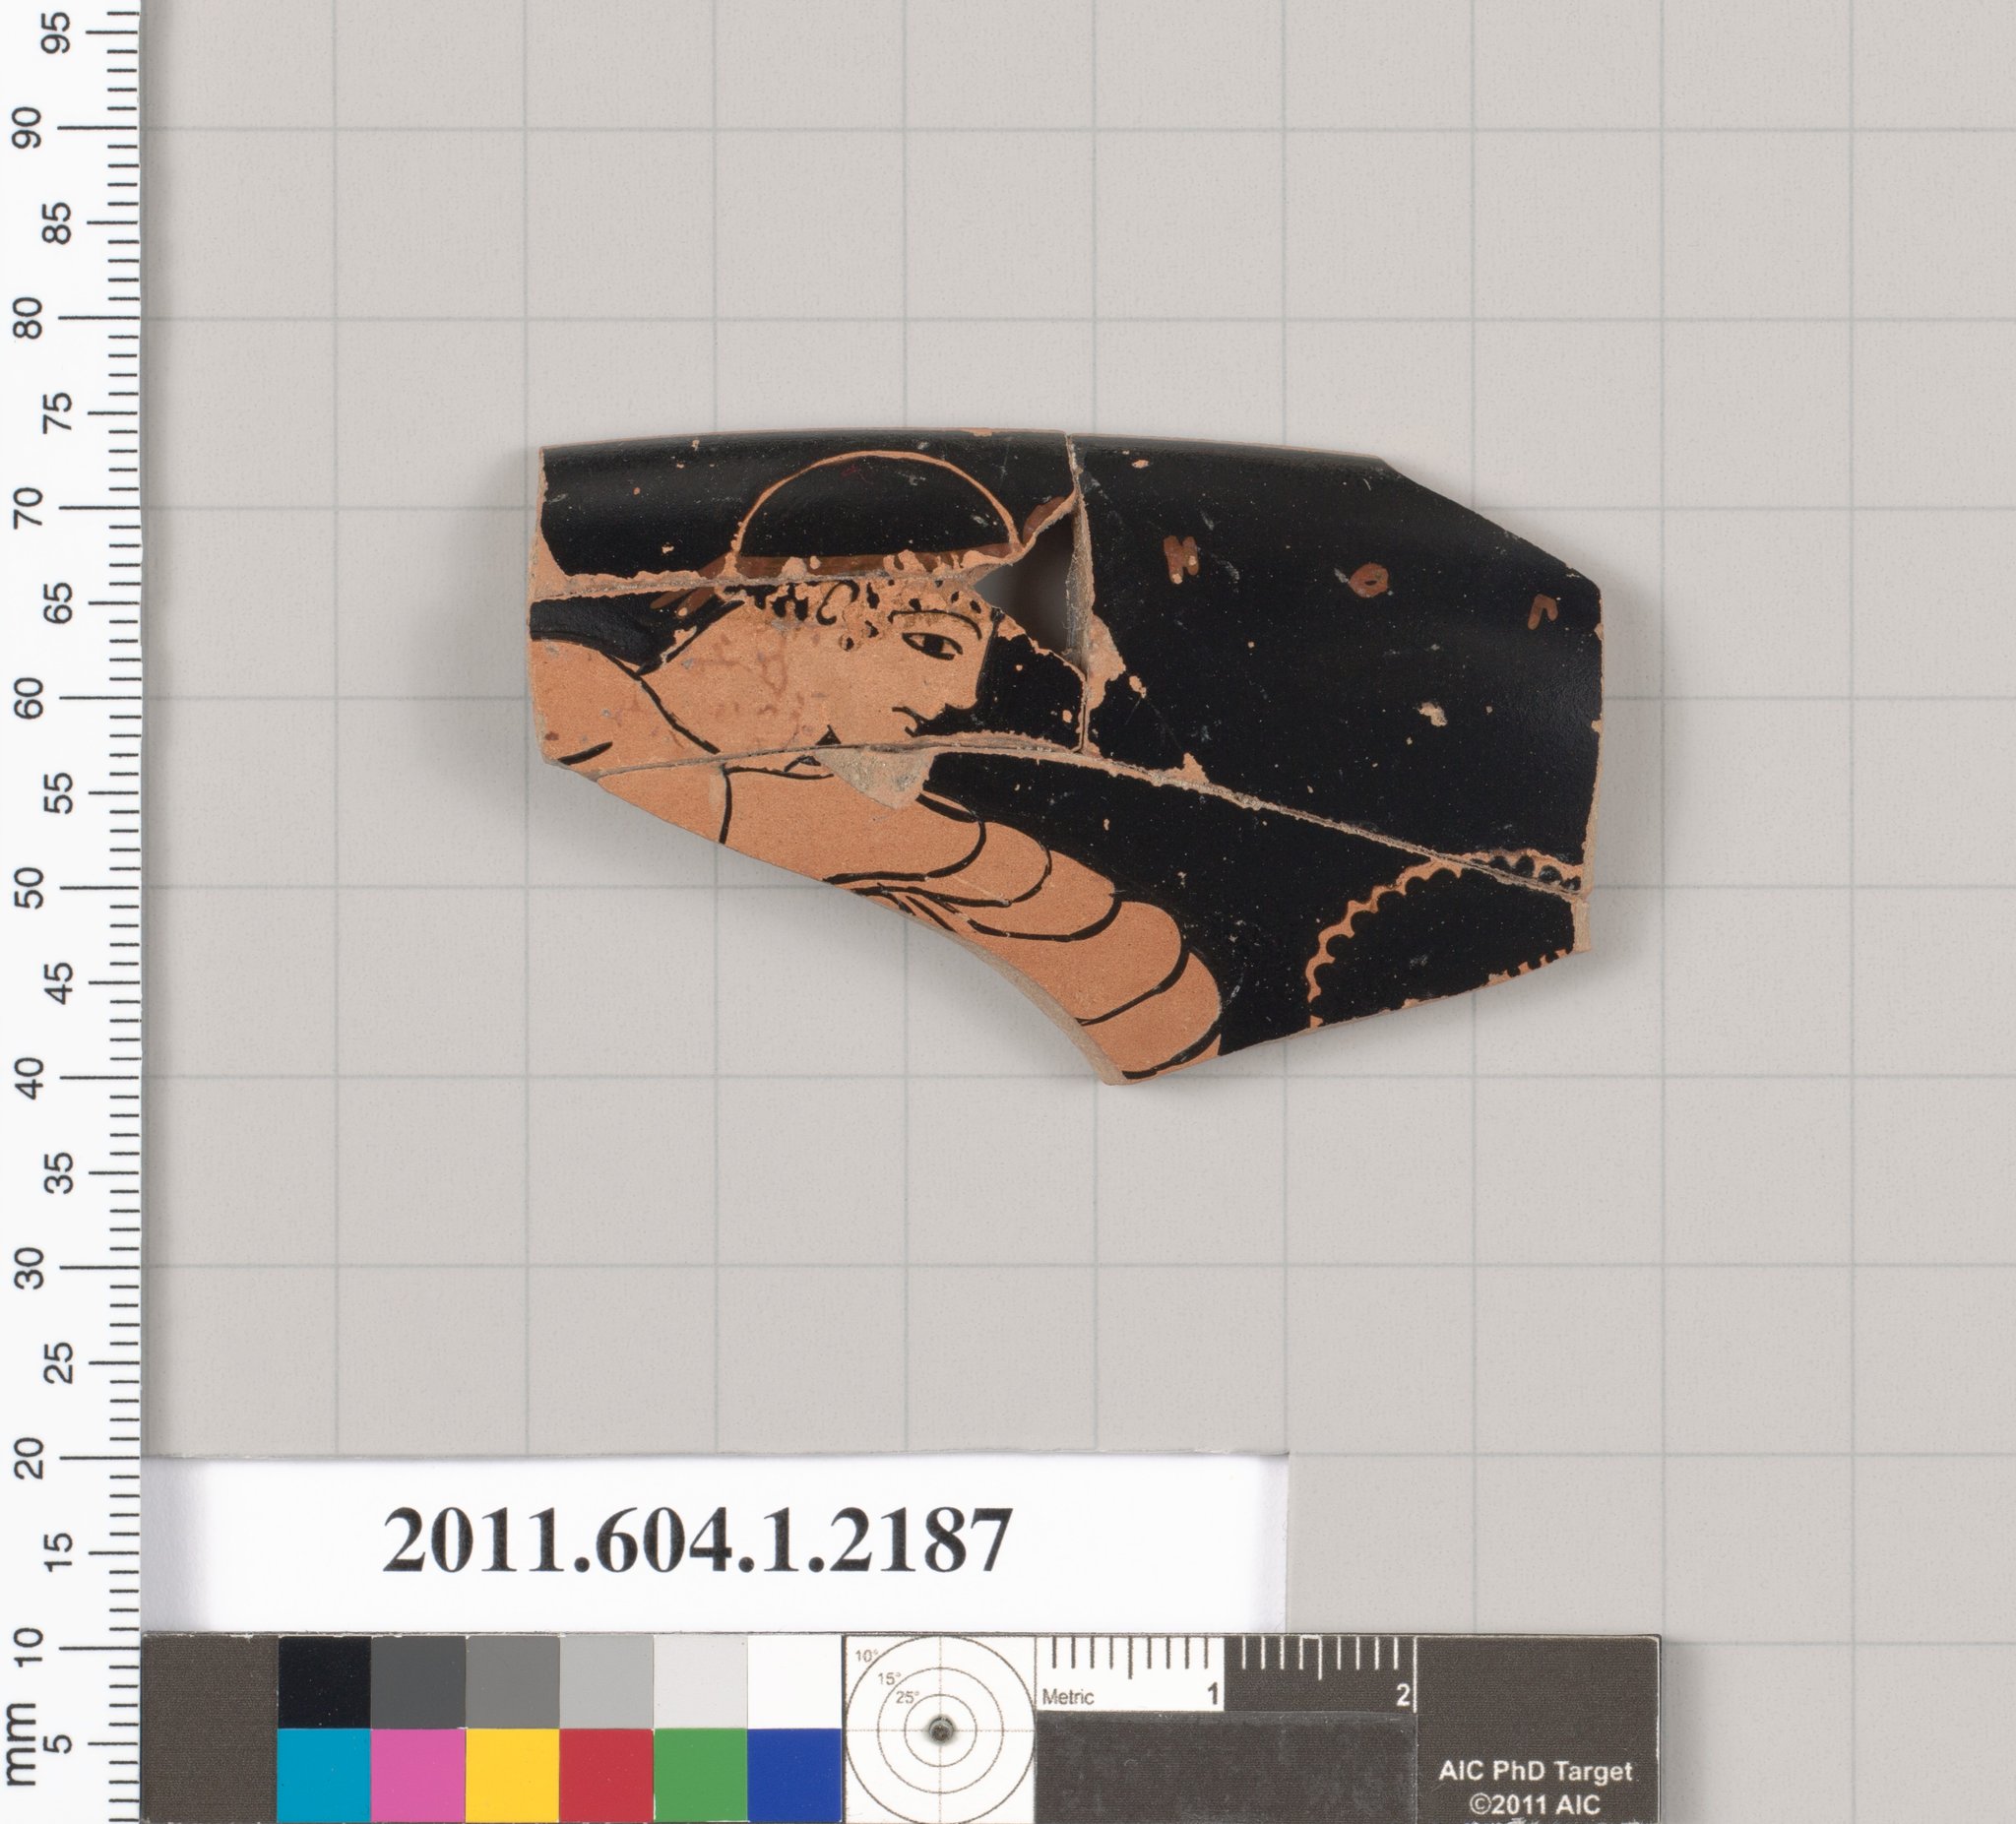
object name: kylix fragment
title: Terracotta rim fragment of a kylix (drinking cup)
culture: greek, attic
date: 401-425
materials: terracotta